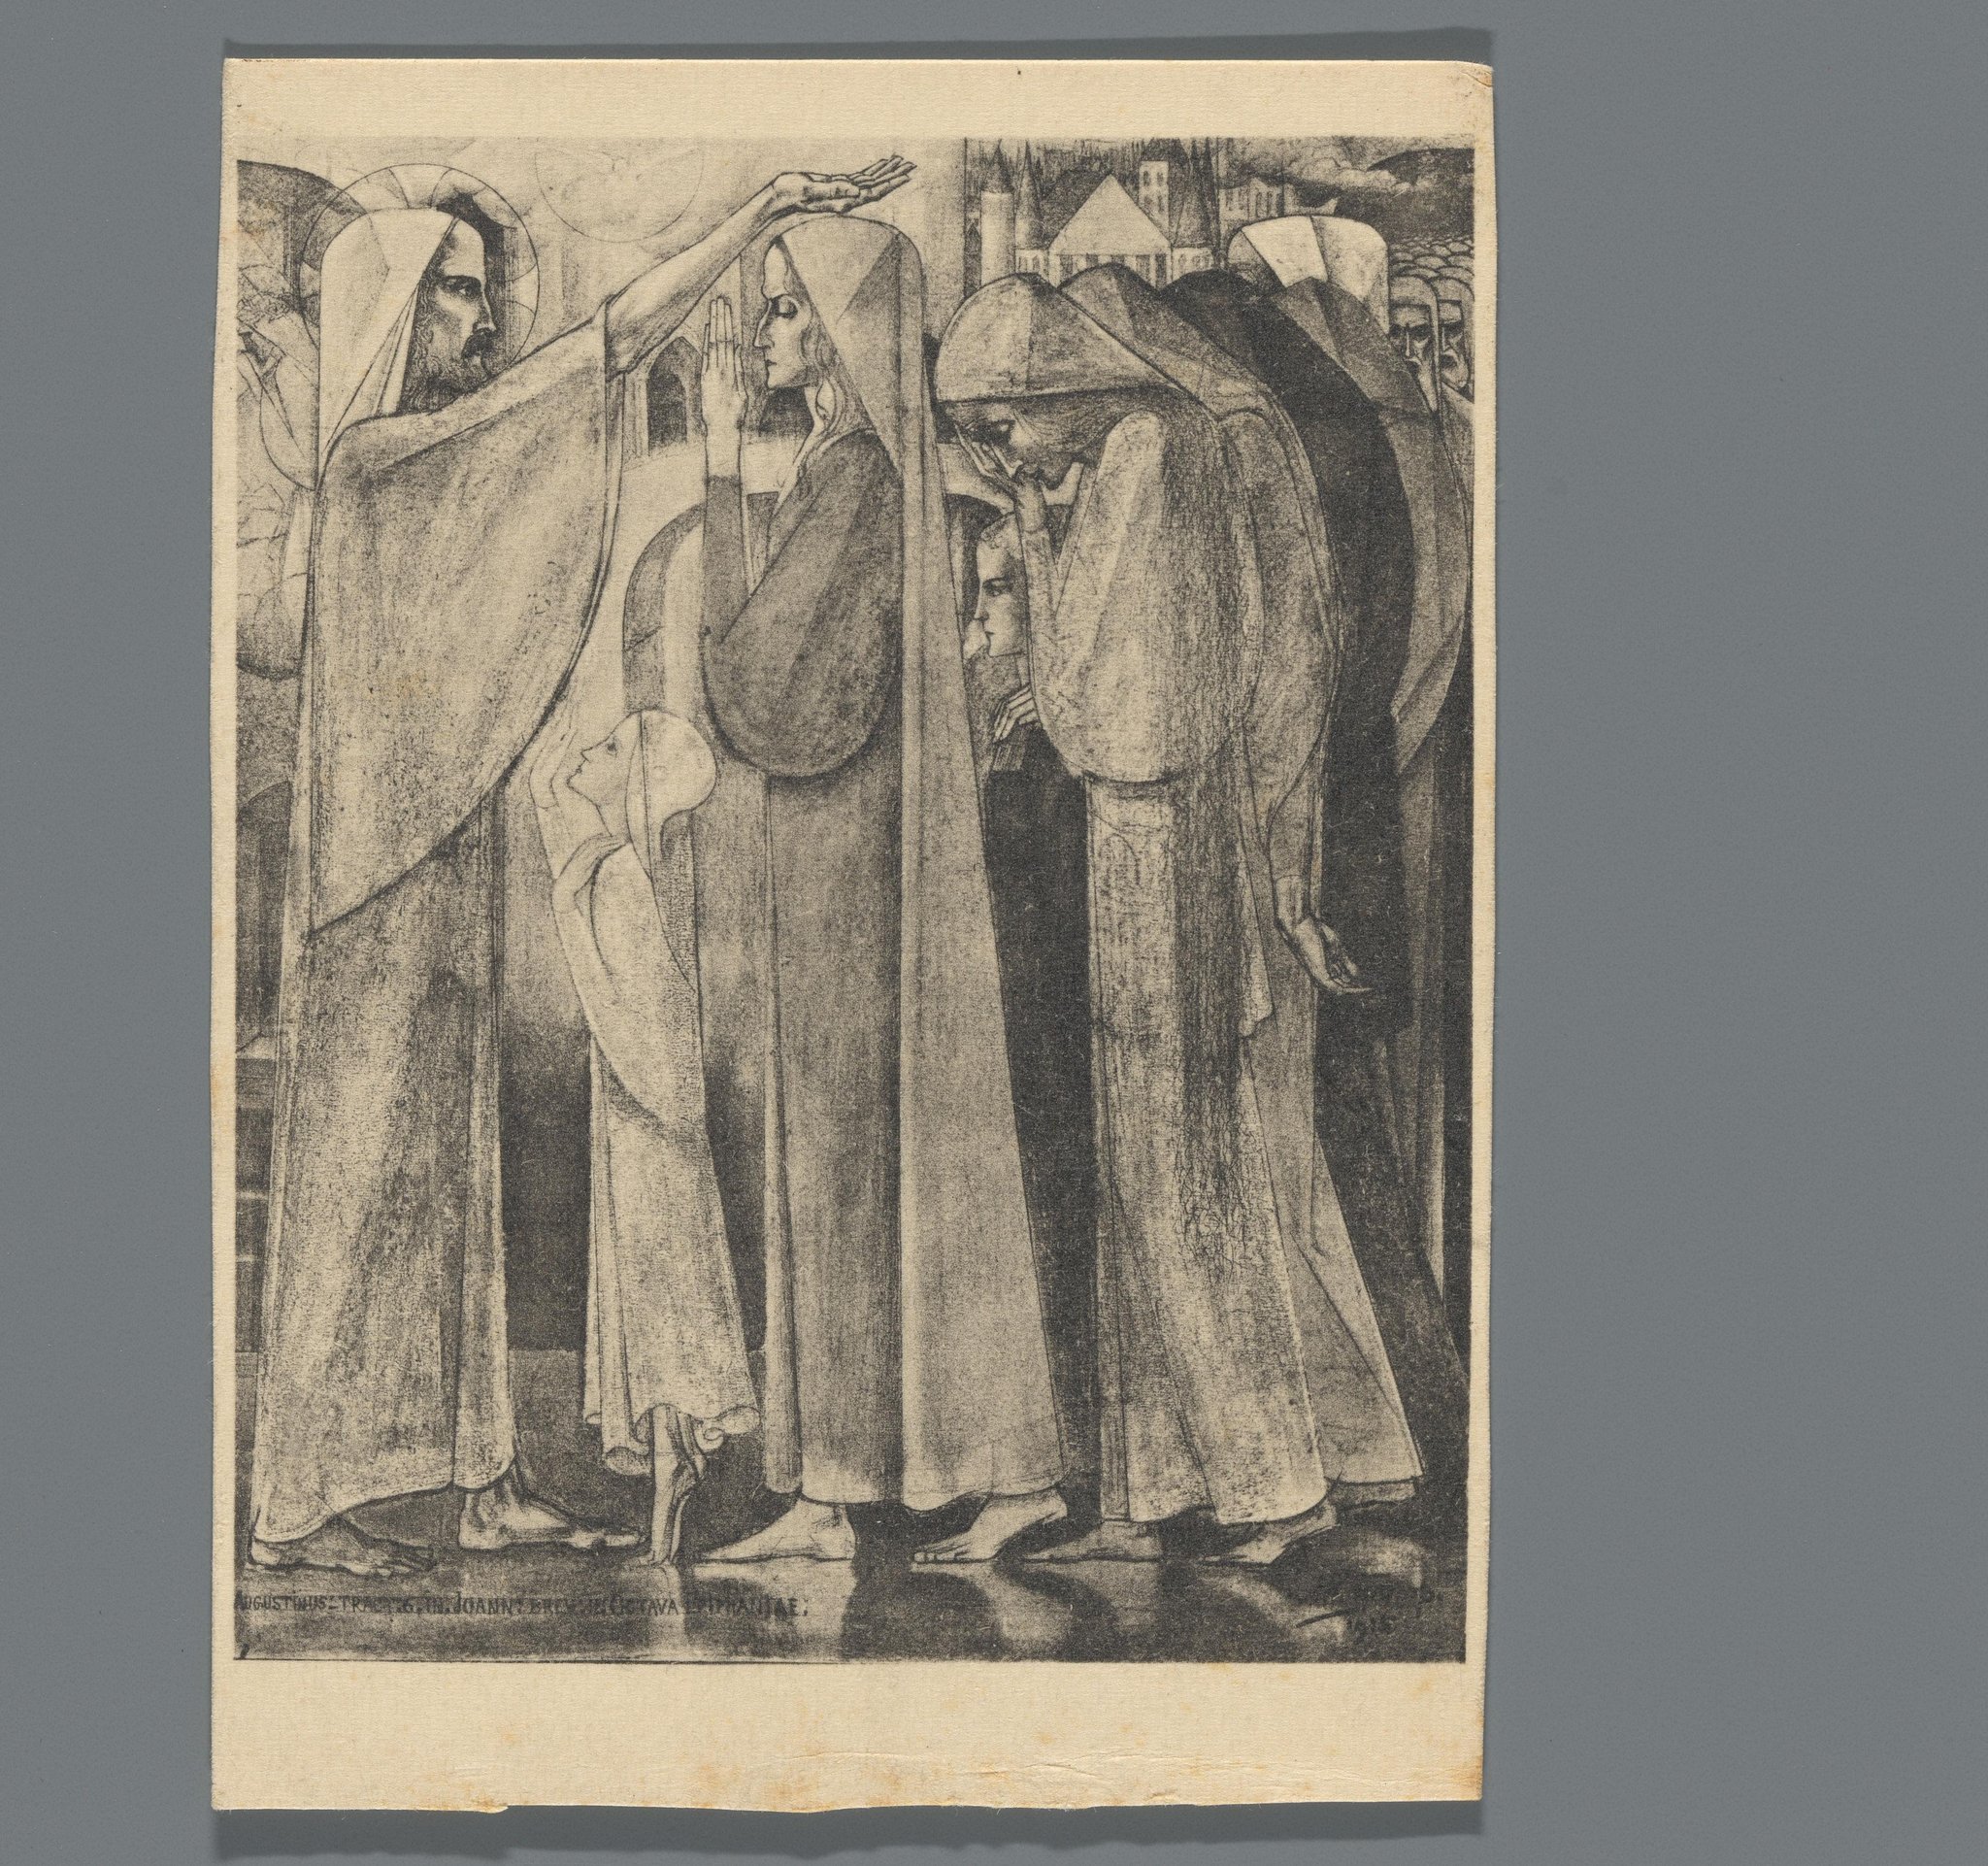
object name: photomechanical print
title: De doop door Christus (volgens Augustinus)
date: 1915-1930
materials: paper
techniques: photograph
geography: amsterdam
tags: christ baptizing (in judea) (john 3:26)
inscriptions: number: ‘P 13’